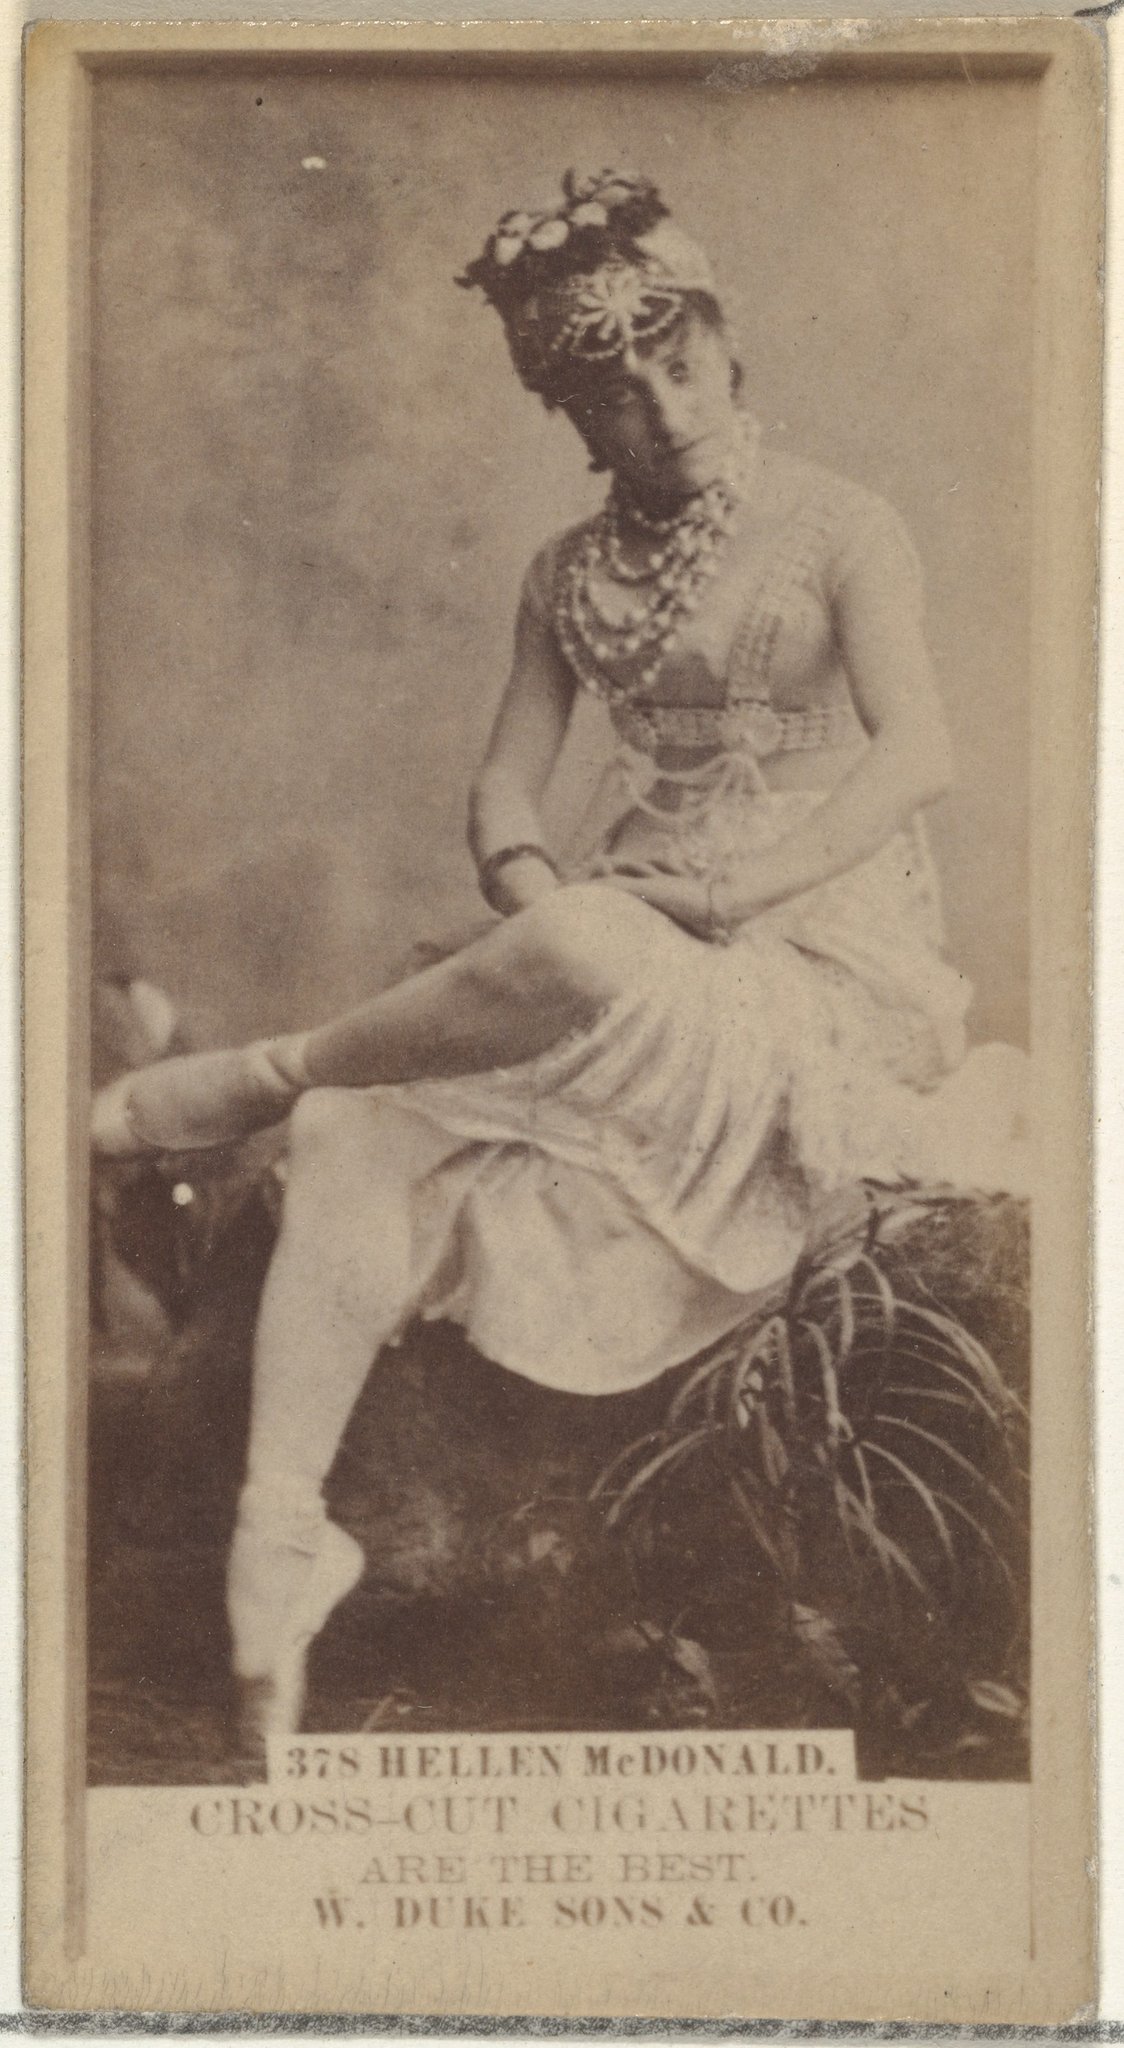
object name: photograph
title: Card Number 378, Helen McDonald, from the Actors and Actresses series (N145-3) issued by Duke Sons & Co. to promote Cross Cut Cigarettes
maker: w. duke, sons & co.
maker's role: publisher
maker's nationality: american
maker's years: 1870-1920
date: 1880-1889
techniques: albumen silver print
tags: portraits,women,actresses